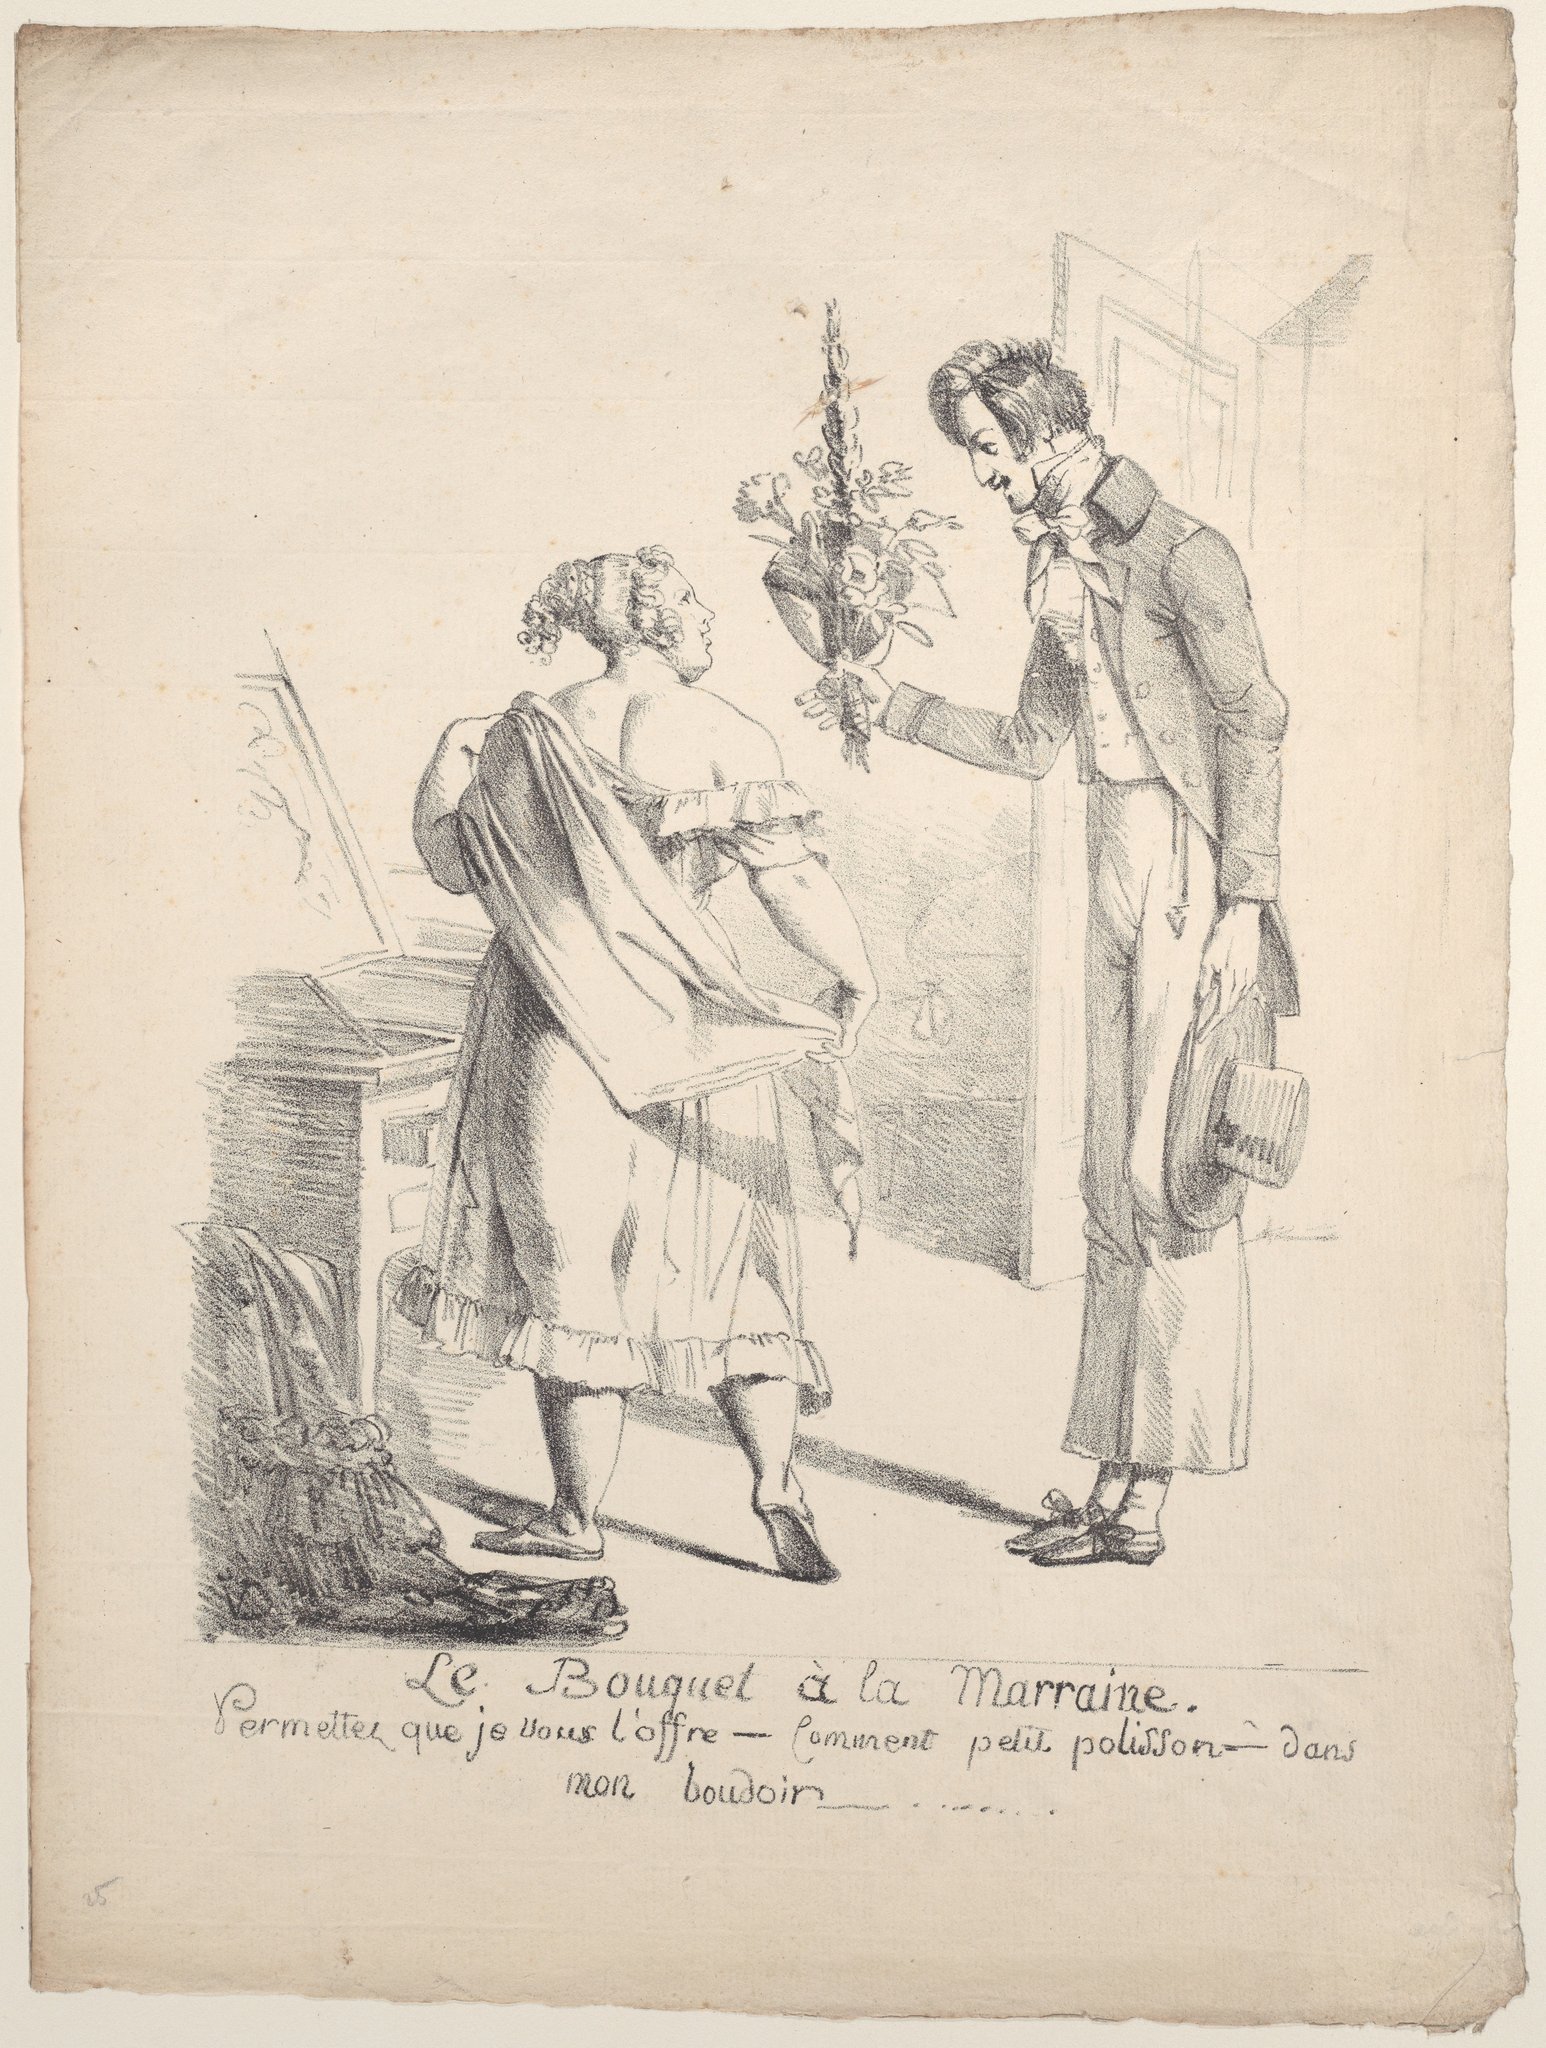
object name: print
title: The Godmother's Bouquet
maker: baron dominique vivant denon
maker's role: artist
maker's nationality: french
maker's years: 1747-1825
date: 1800-1825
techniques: lithograph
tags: men,women,flowers